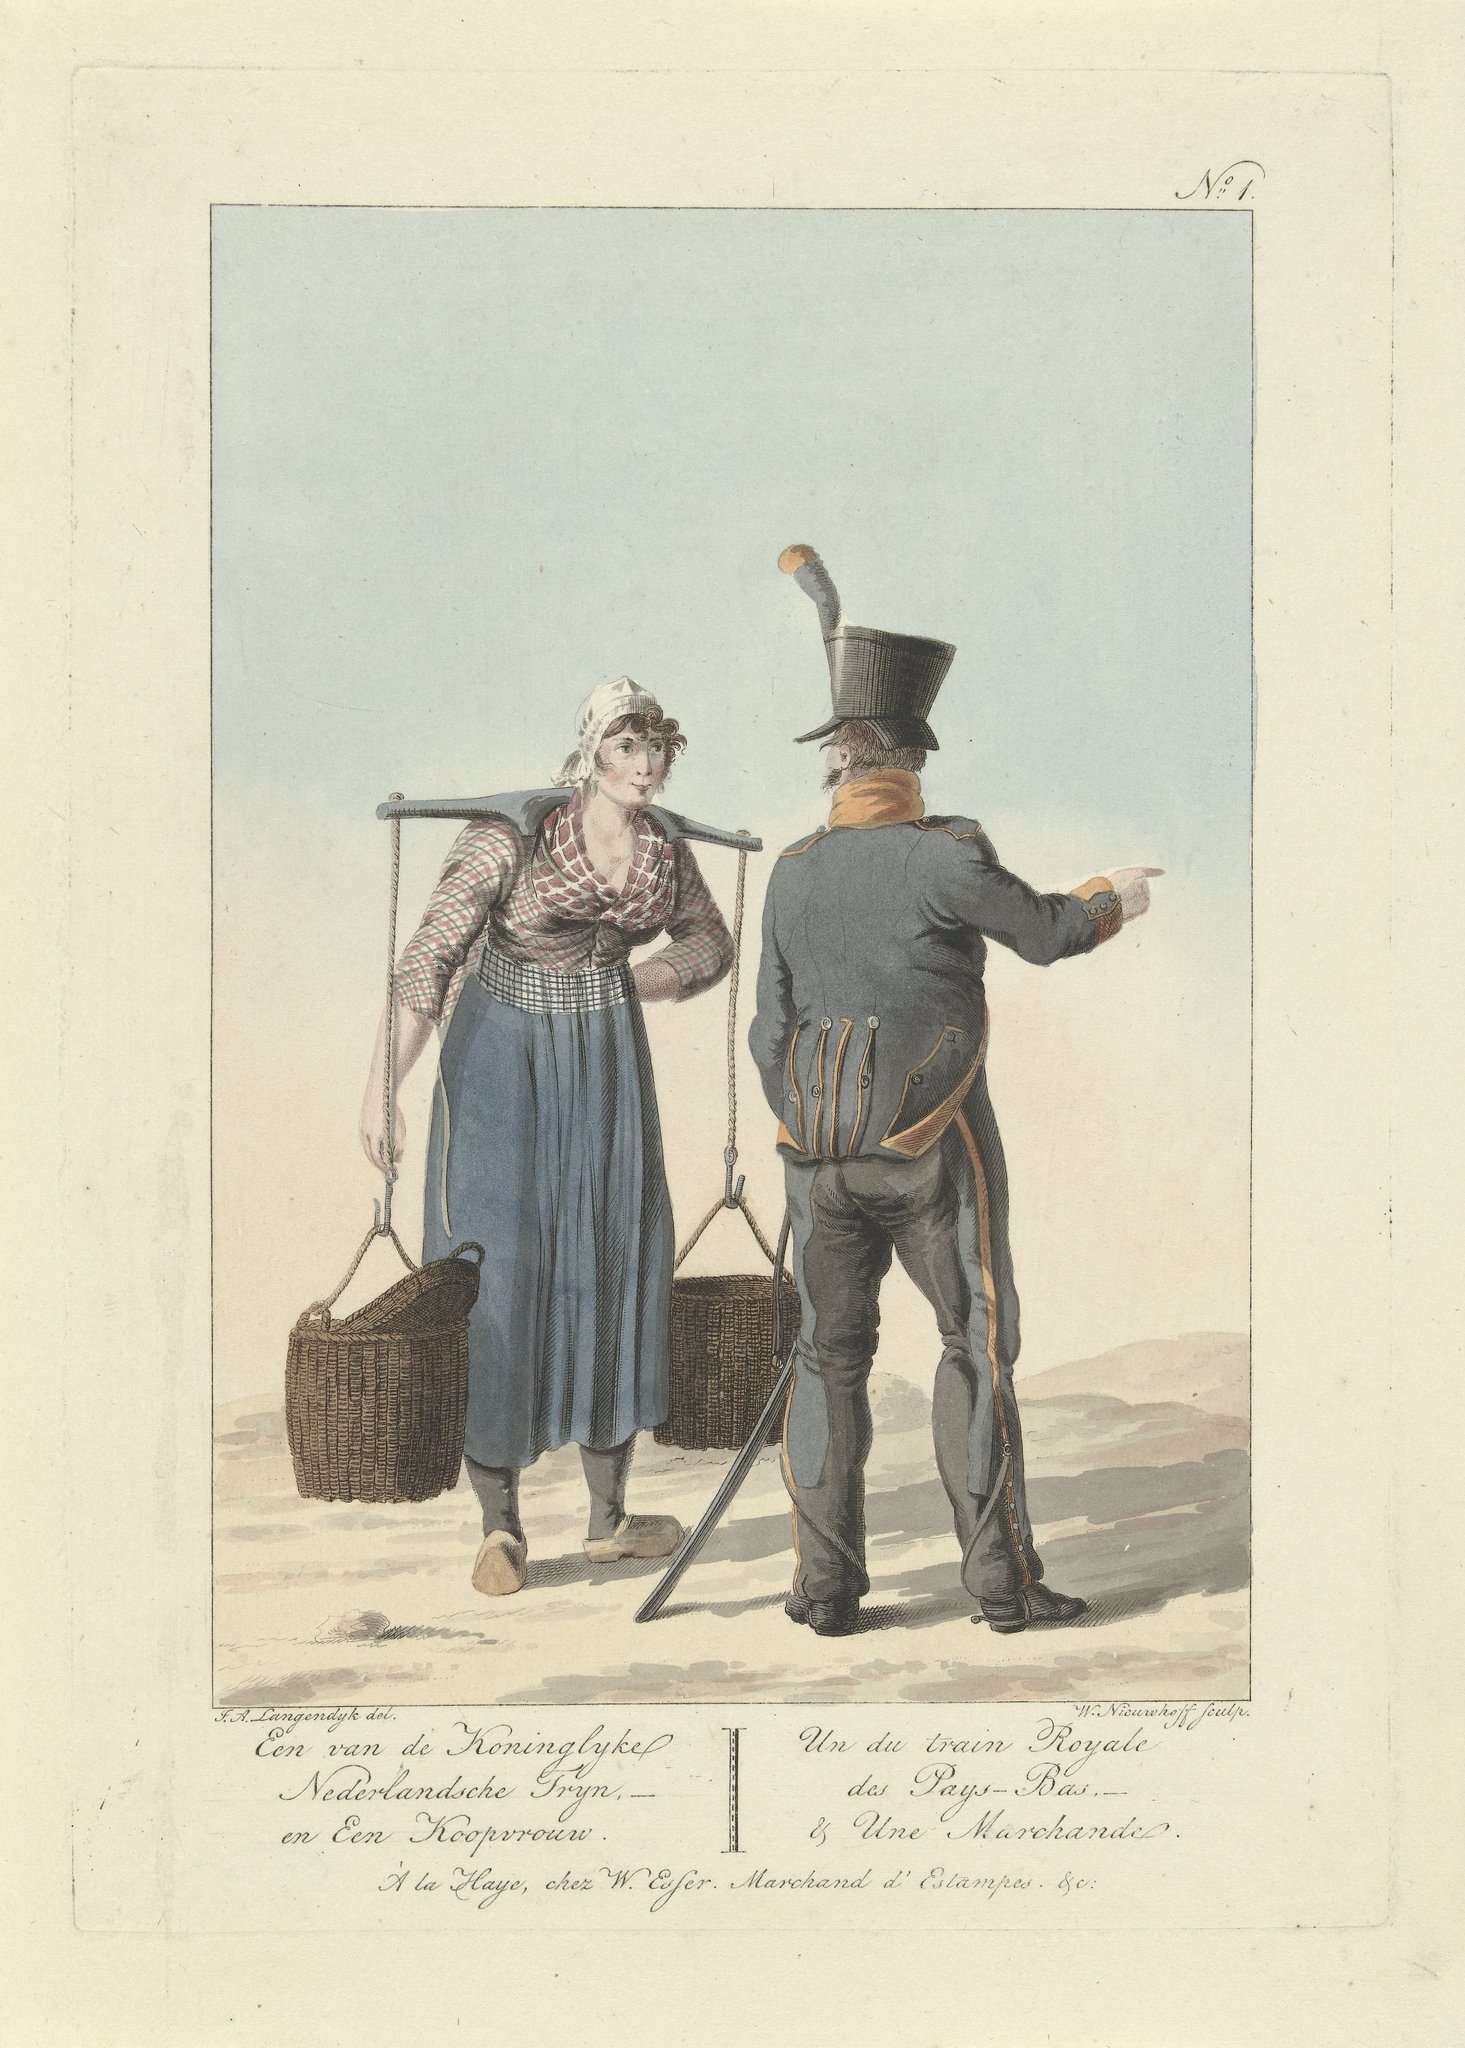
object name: costume print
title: Een van de Koninglijke Nederlandsche Trijn, en Een Koopvrouw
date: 1816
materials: paper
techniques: etching, hand coloring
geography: the hague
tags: private soldier, merchant, salesman - bb - women engaged in trade and commerce, (military) uniforms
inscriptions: collector's mark: Lugt 2228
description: Een soldaat van de Koninklijke Nederlandse landmilitie op de rug gezien, 1816. Naast hem staat een koopvrouw met twee manden aan het juk op haar schouders. Onderaan in de marge de titel in het Nederlands en in het Frans.